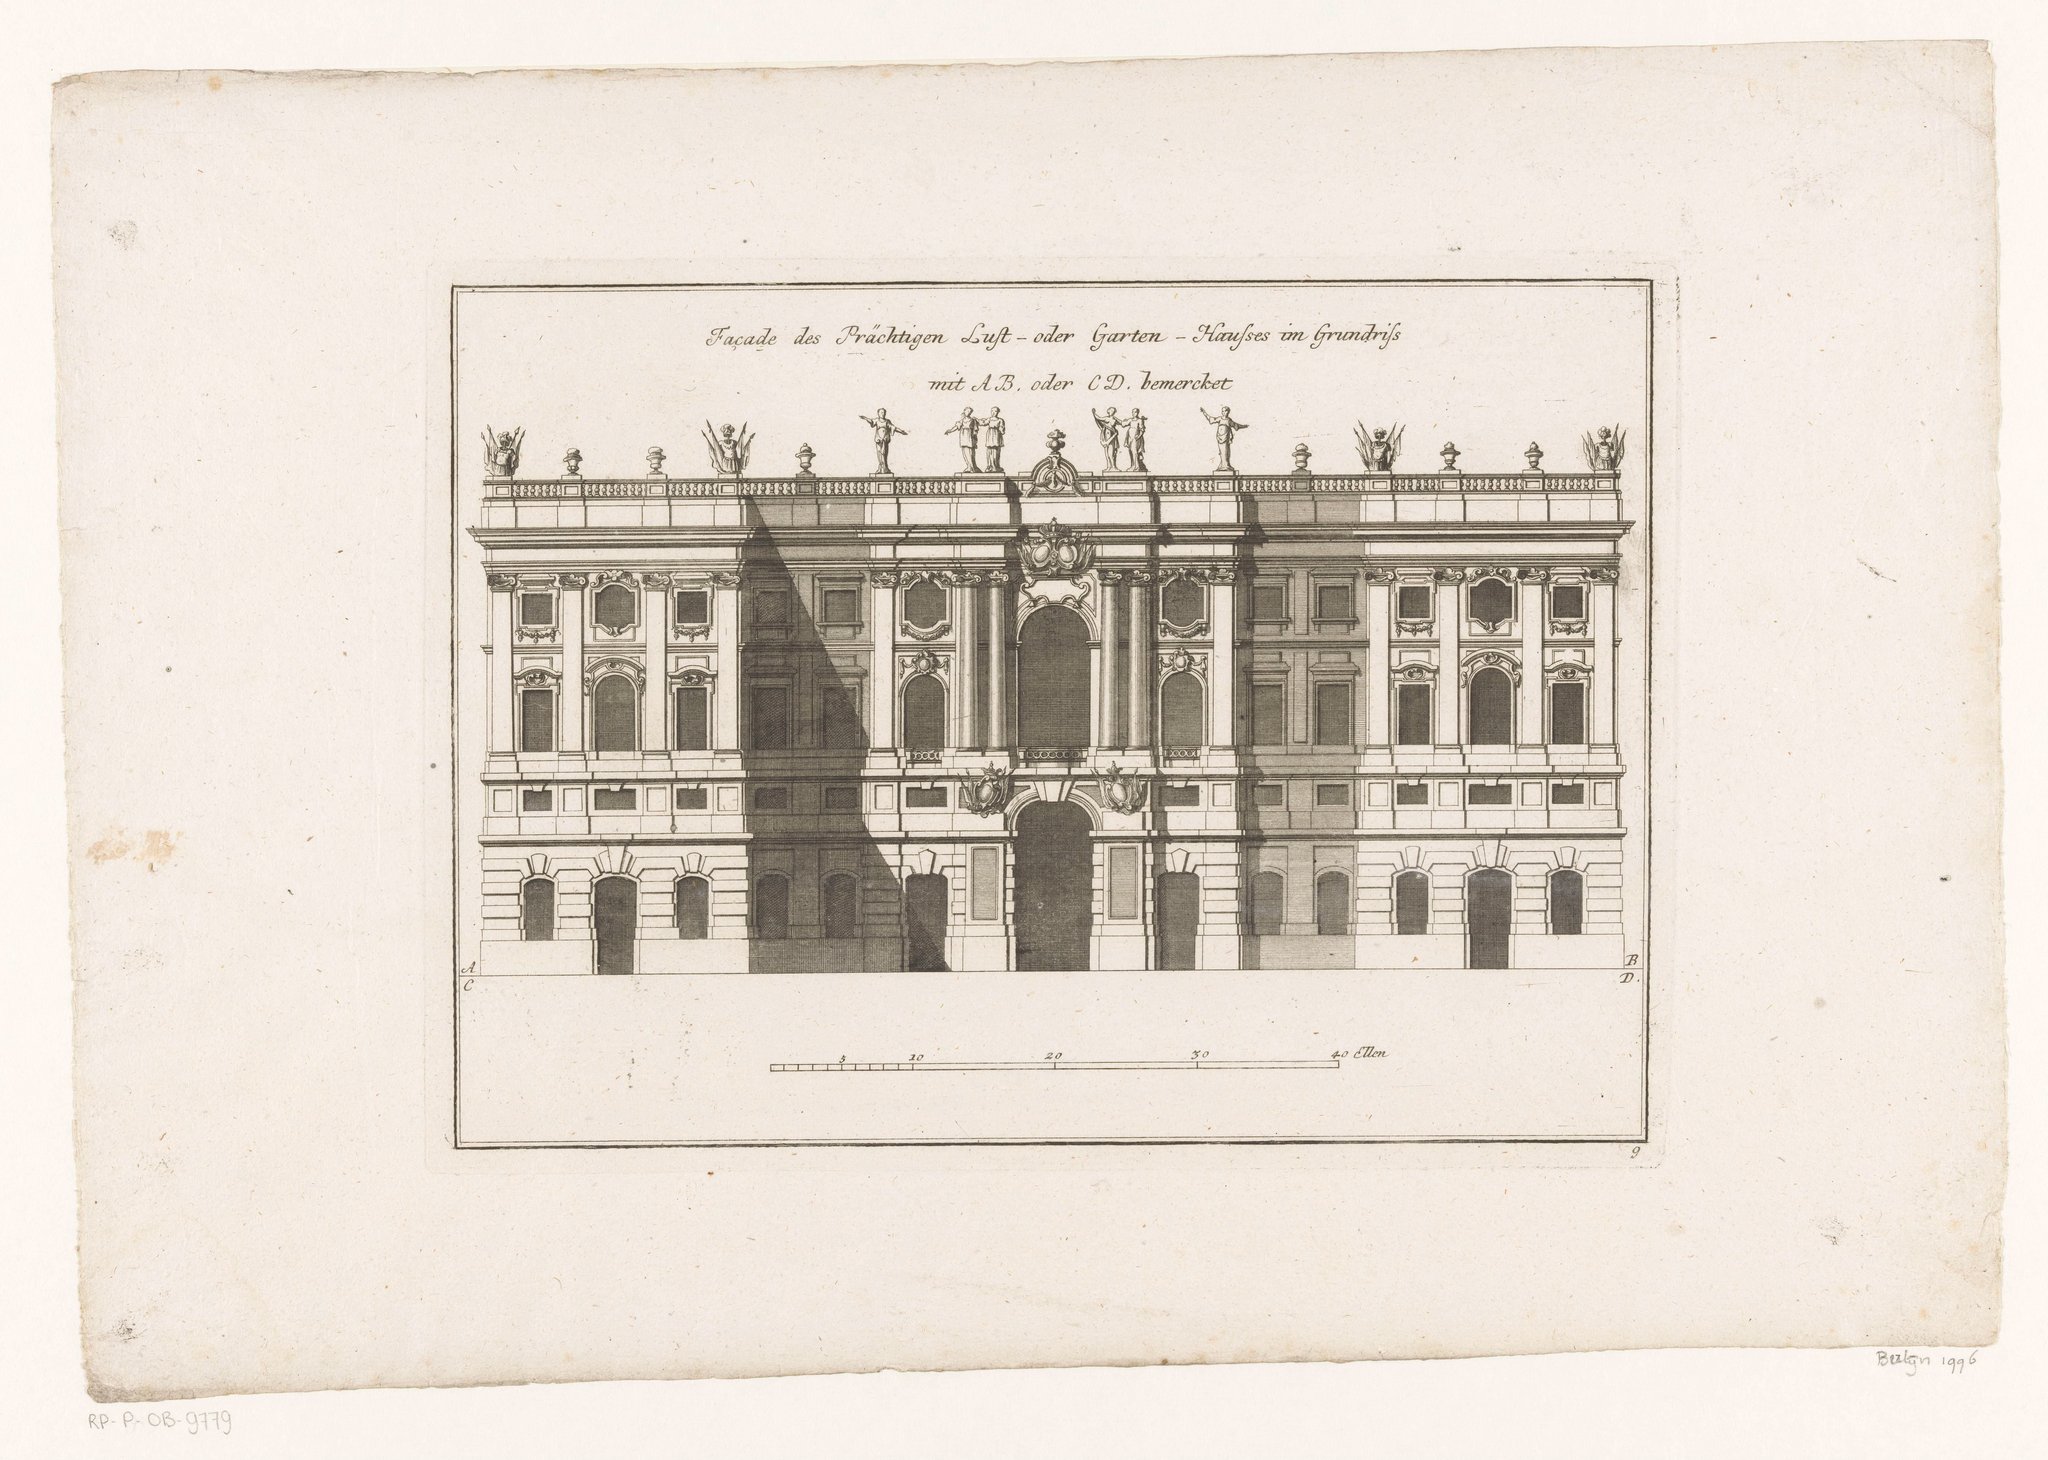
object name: print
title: Façade van een tuinpaviljoen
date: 1729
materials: paper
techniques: engraving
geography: nuremberg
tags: summer-house, arbour, garden-house (dutch: 'theekoepel'), façade (of house or building)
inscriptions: collector's mark: Lugt 2228